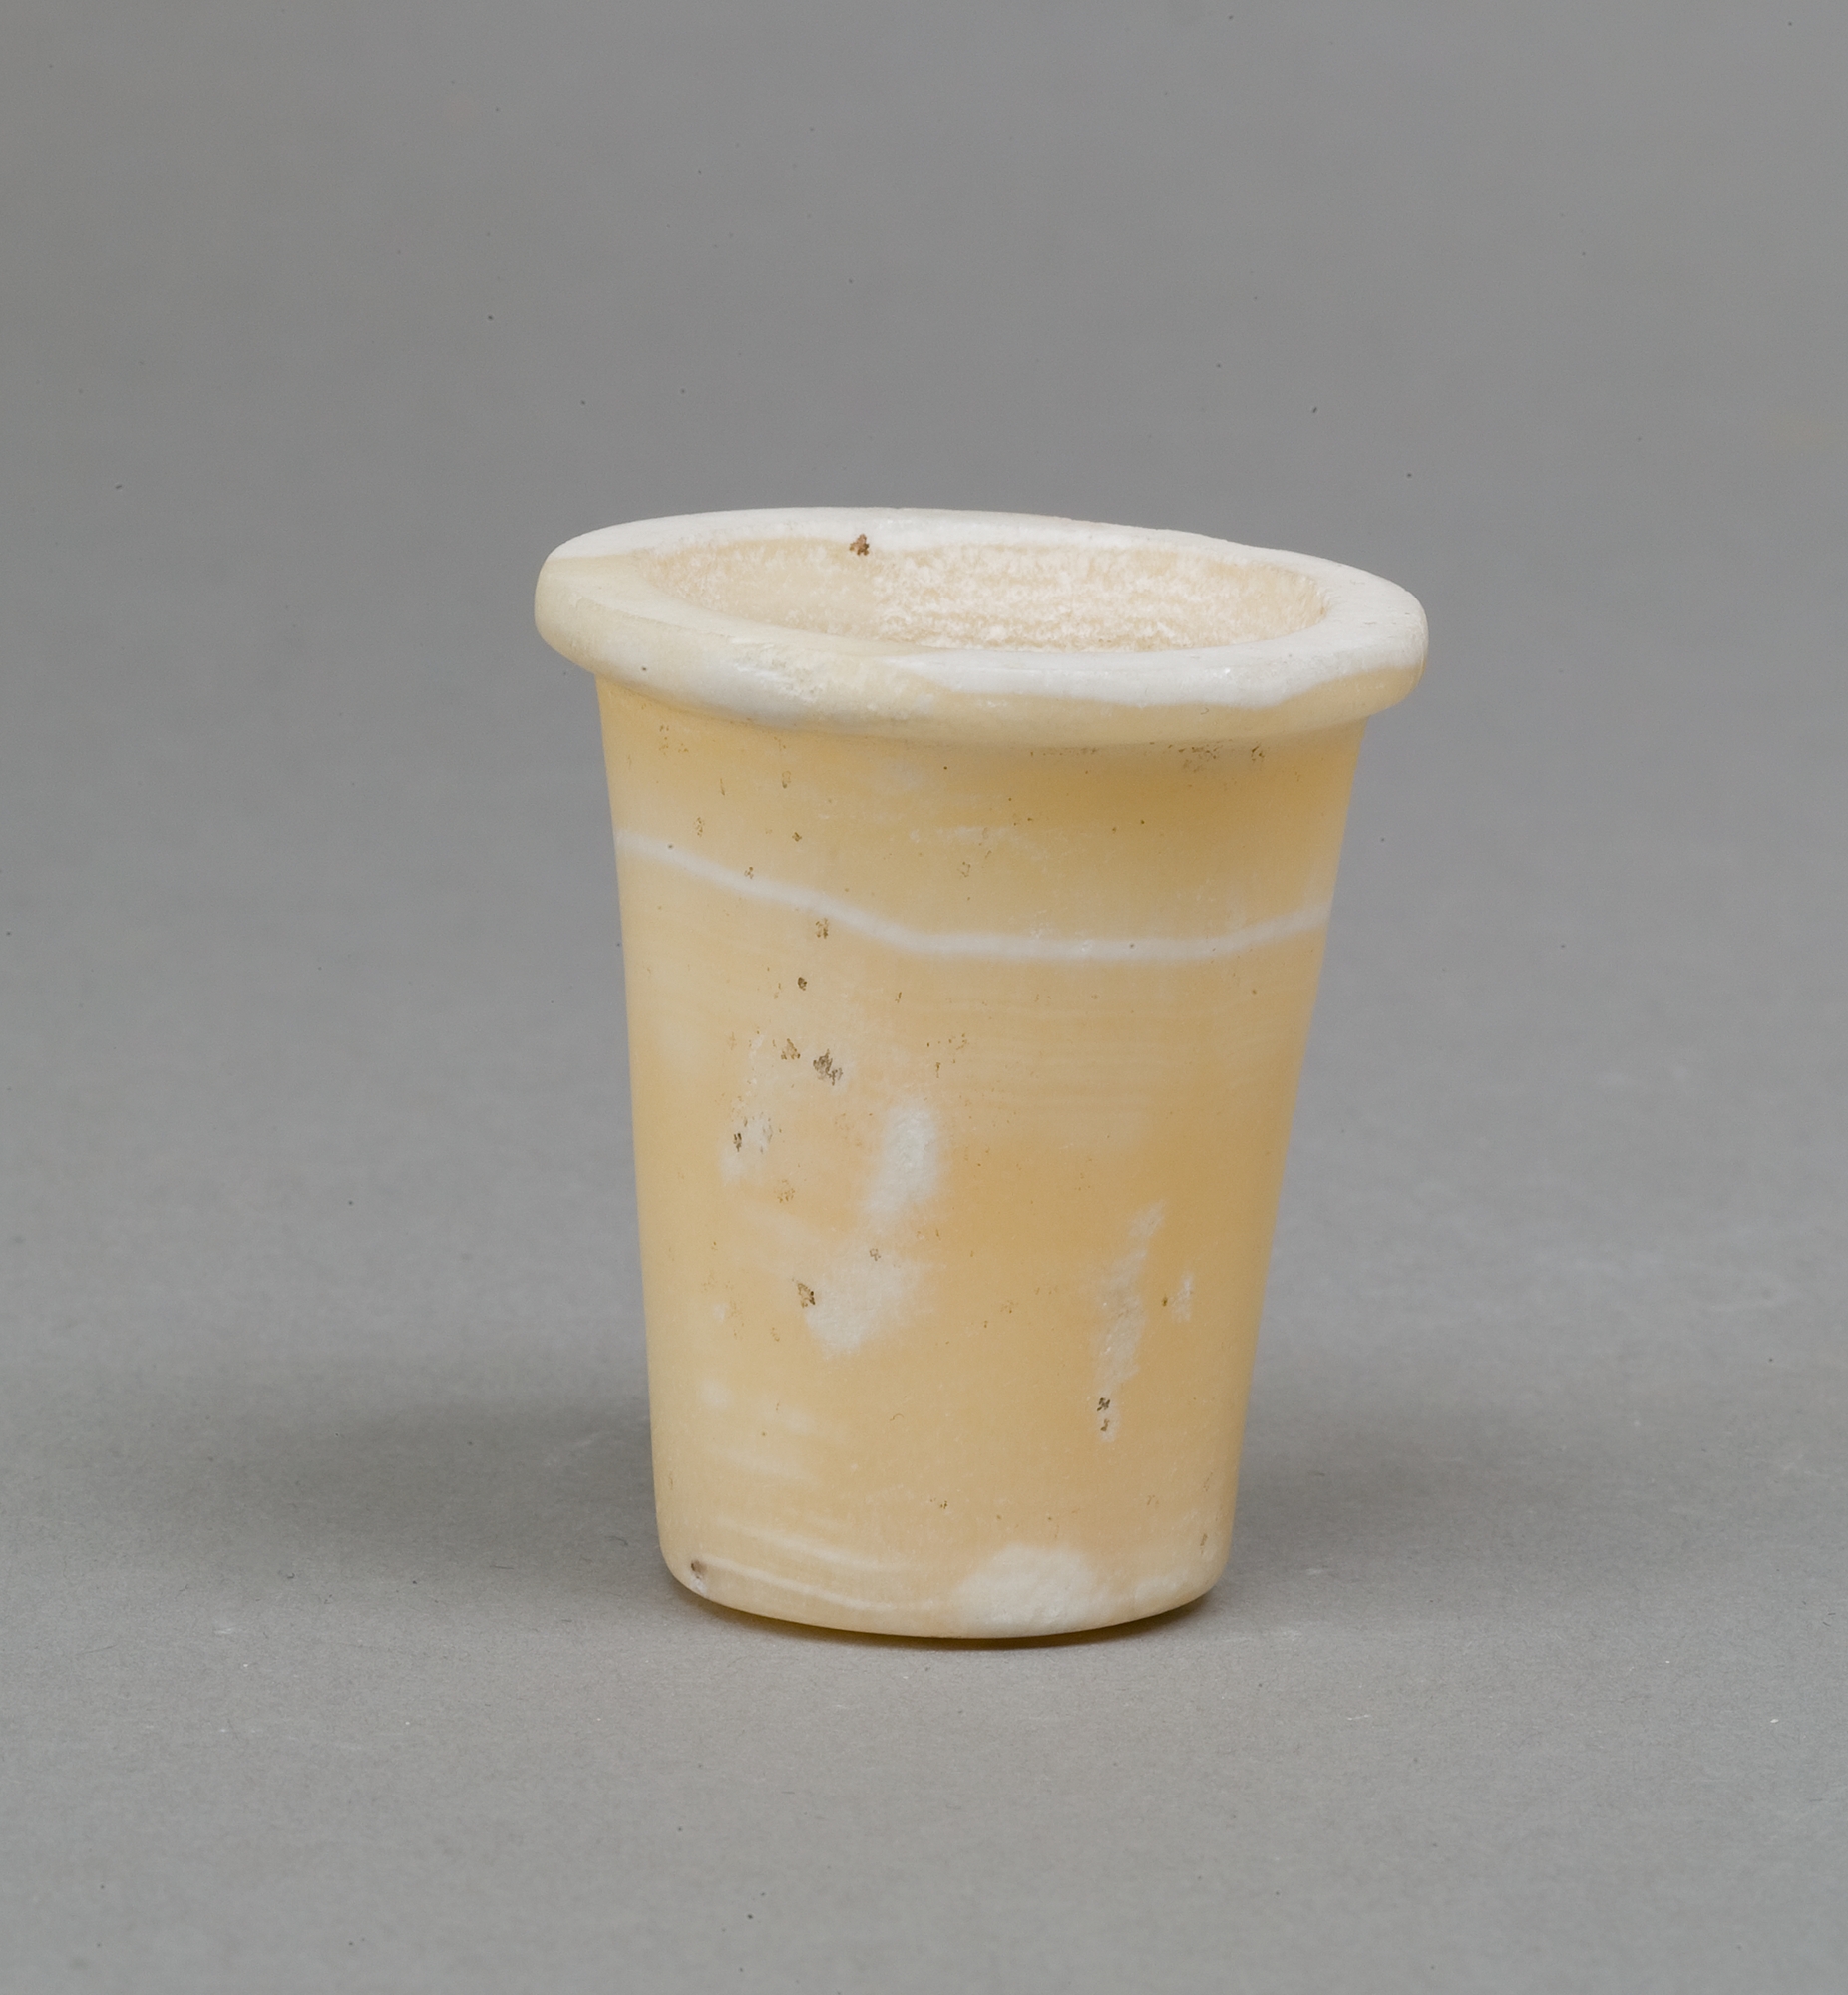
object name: jar, oil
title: Senwosret (?), Oil jar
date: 1950-1850 BCE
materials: stone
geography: egypt